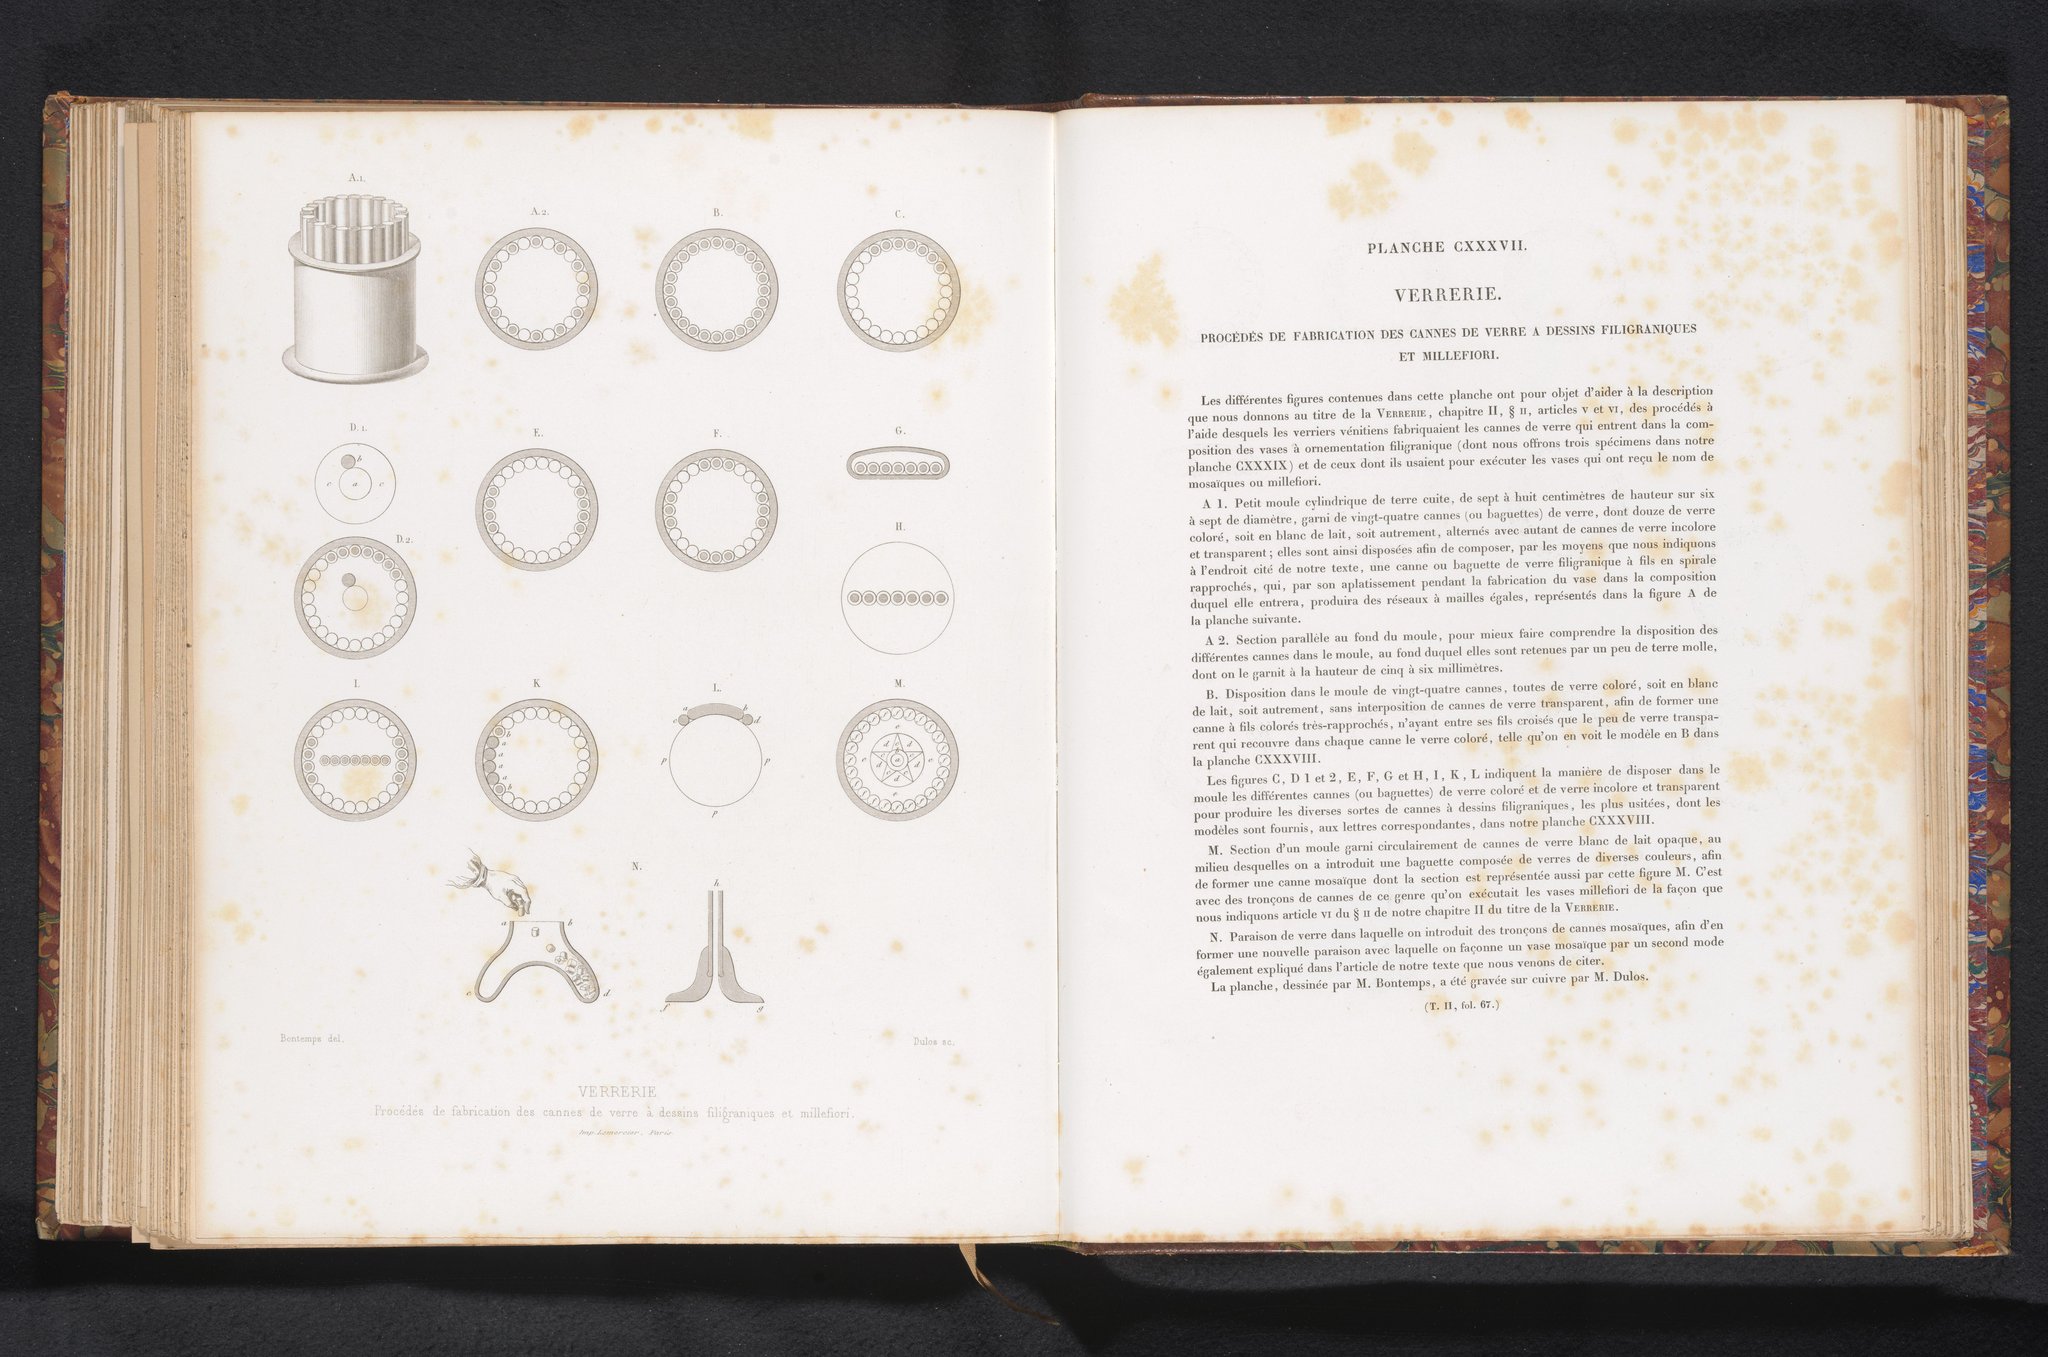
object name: page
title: Reproductie van een ontwerp van het productieproces van filigraan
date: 1859-1864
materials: paper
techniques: photoaquatint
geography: paris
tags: glass industry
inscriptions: name: ‘A. Noël del./ Dulos sc.’